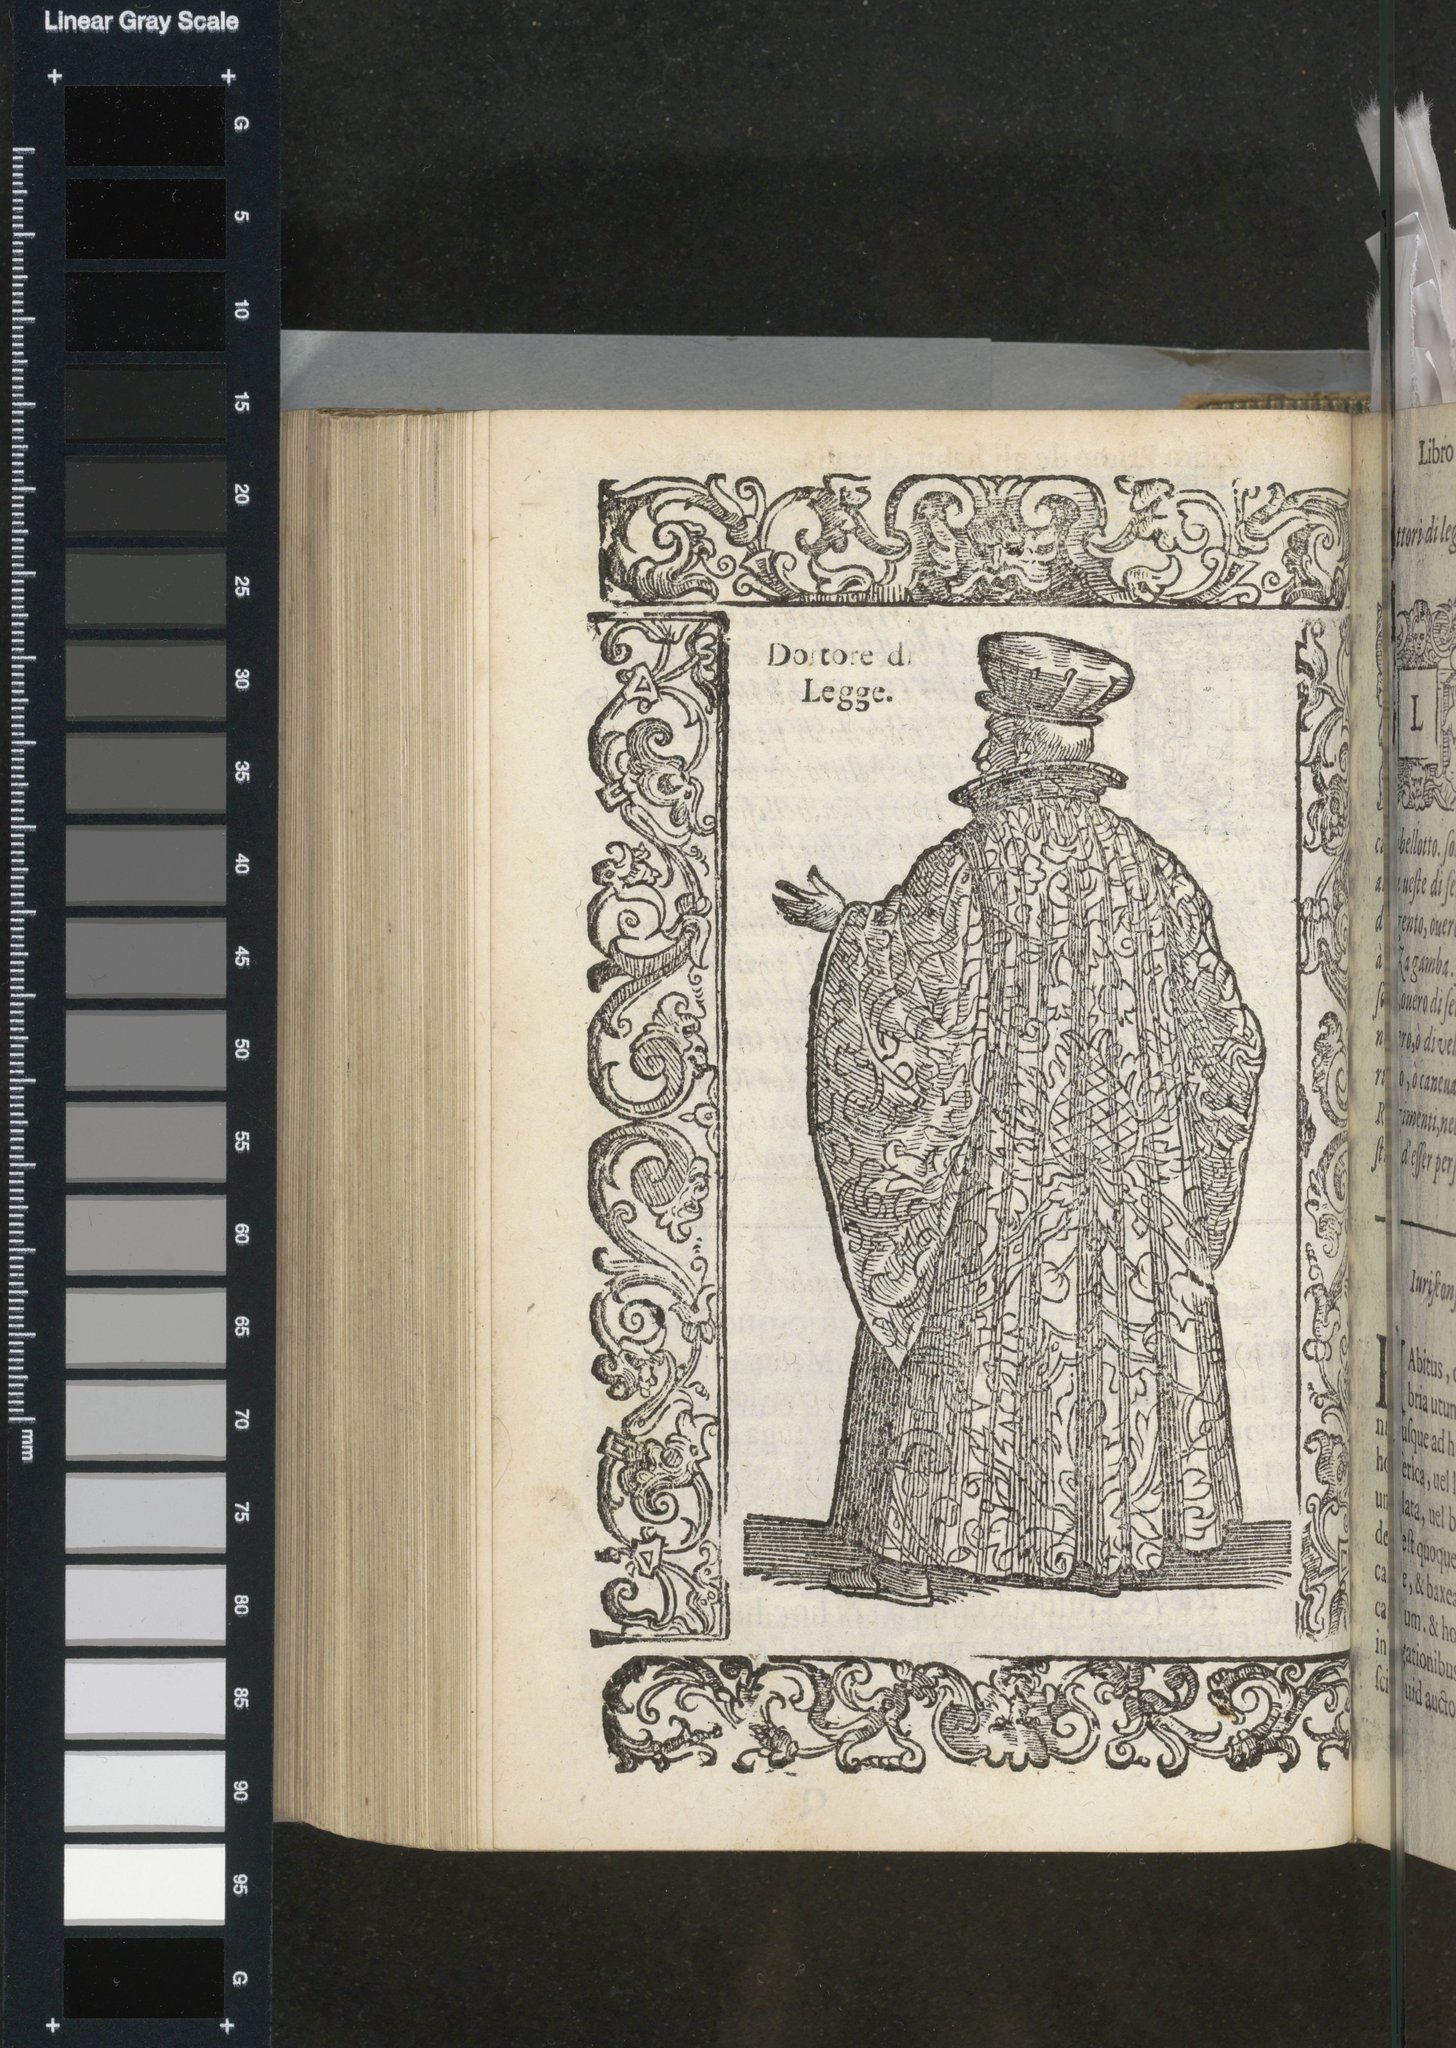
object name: costume print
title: Dottore di legge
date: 1598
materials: paper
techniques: woodcut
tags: fashion plates